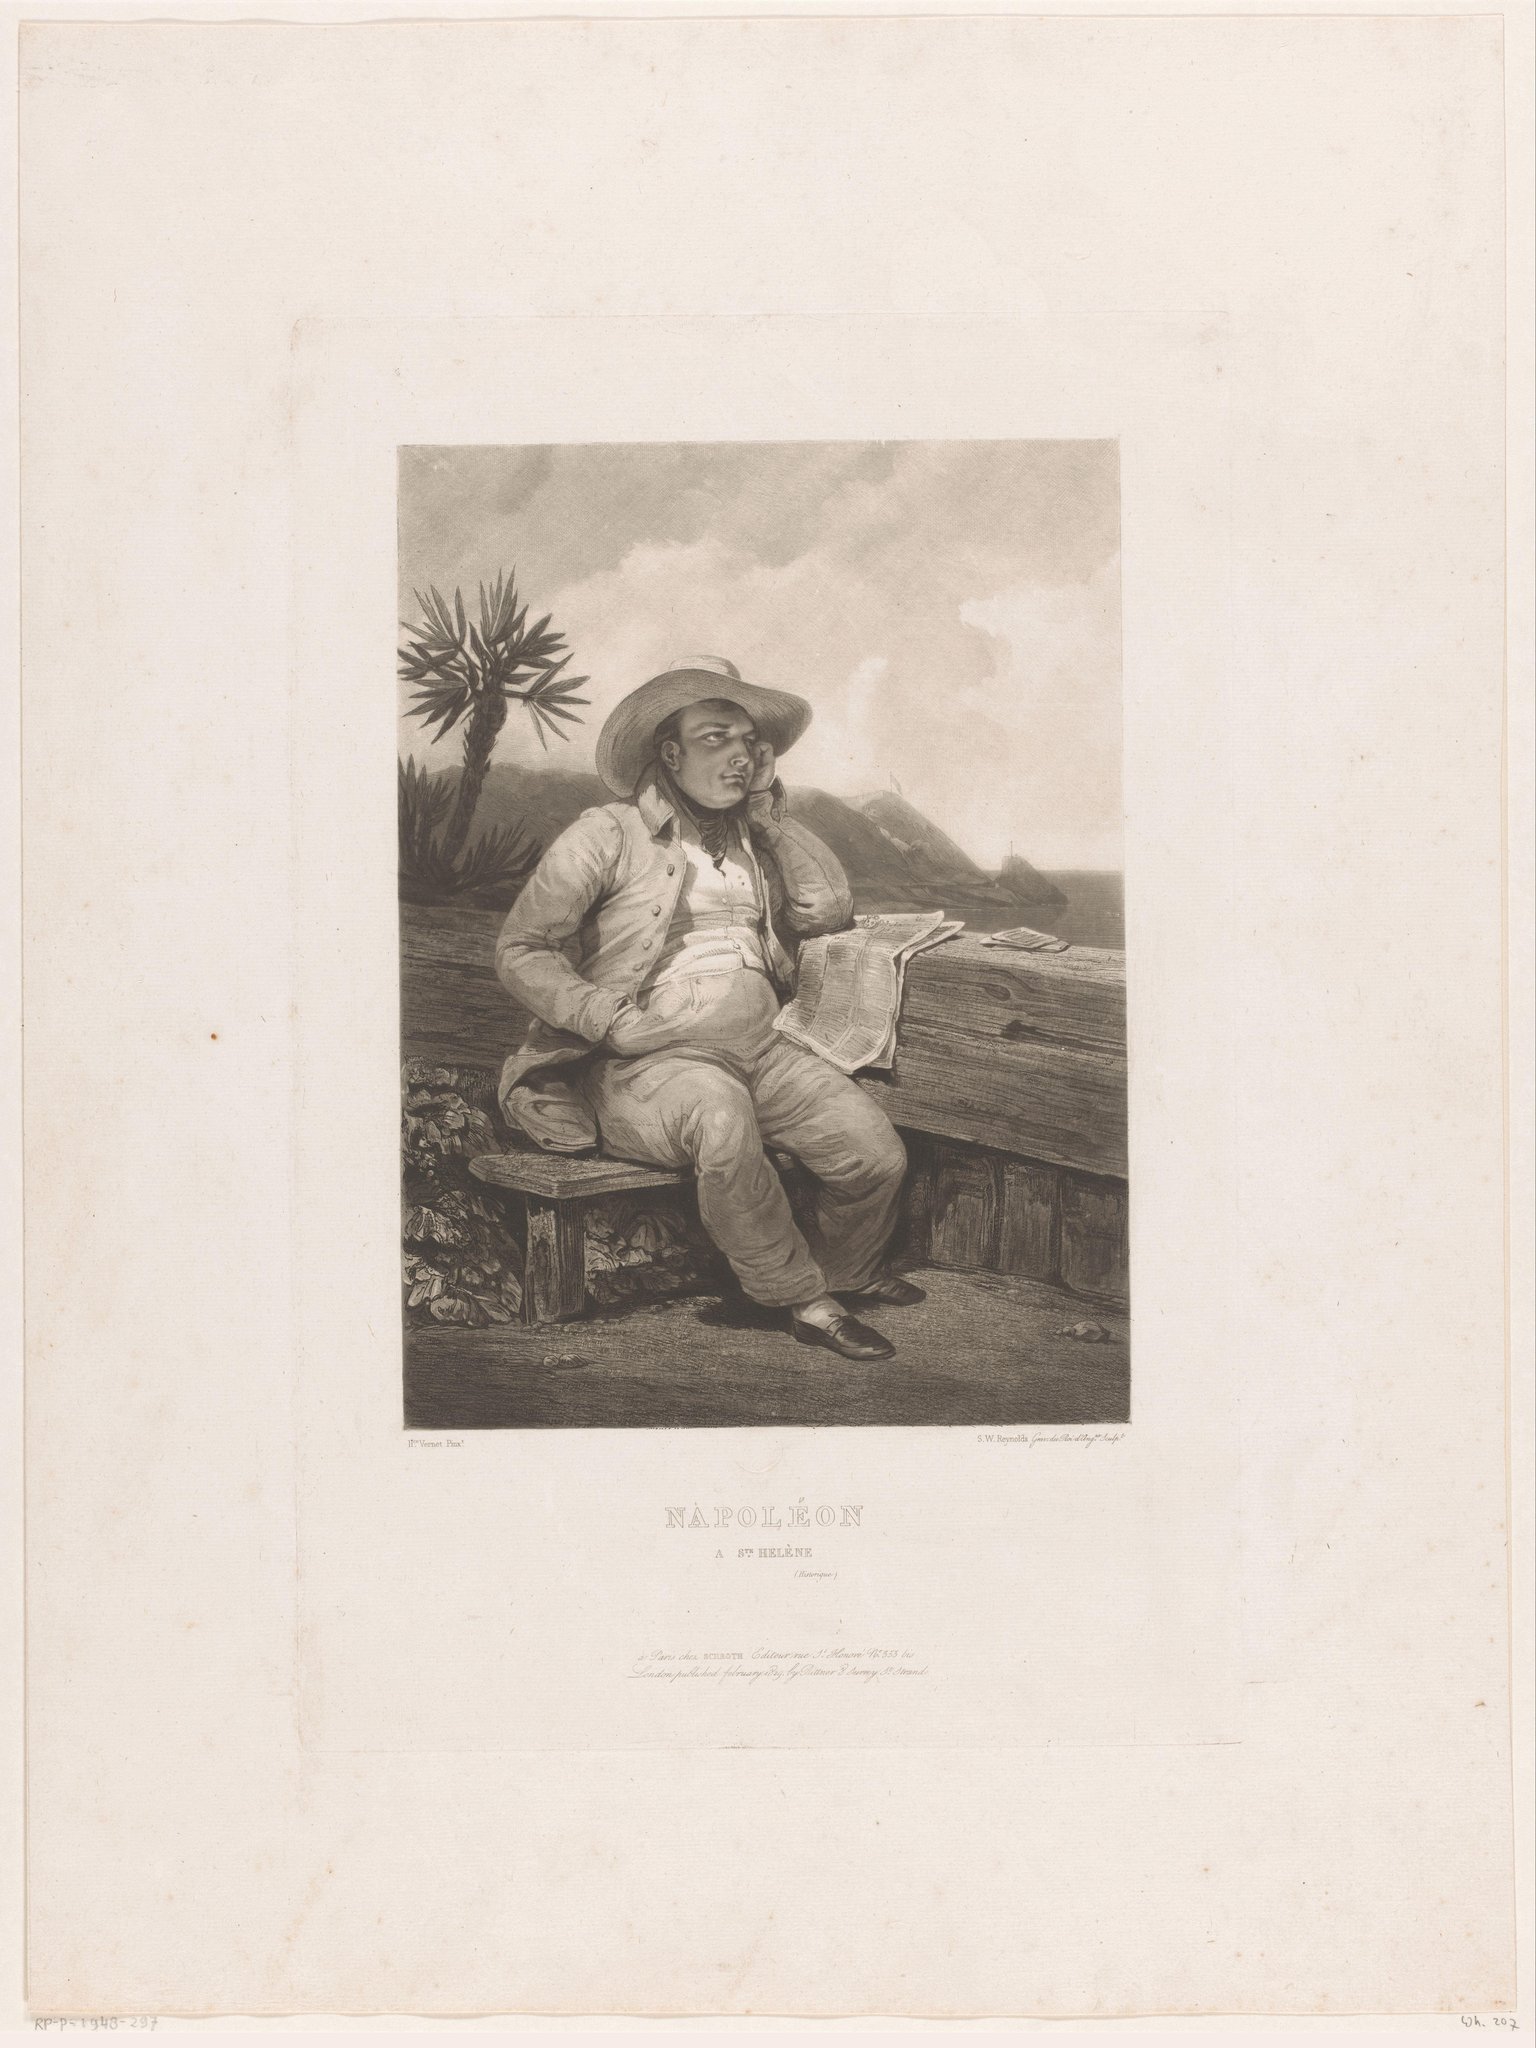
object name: print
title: Portret van Napoleon Bonaparte, zittend in Sint-Helena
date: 1825-1840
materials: paper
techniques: etching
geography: paris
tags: paris, vienna, historical persons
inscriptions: collector's mark: Lugt 2228, check stamp: Lugt 634b